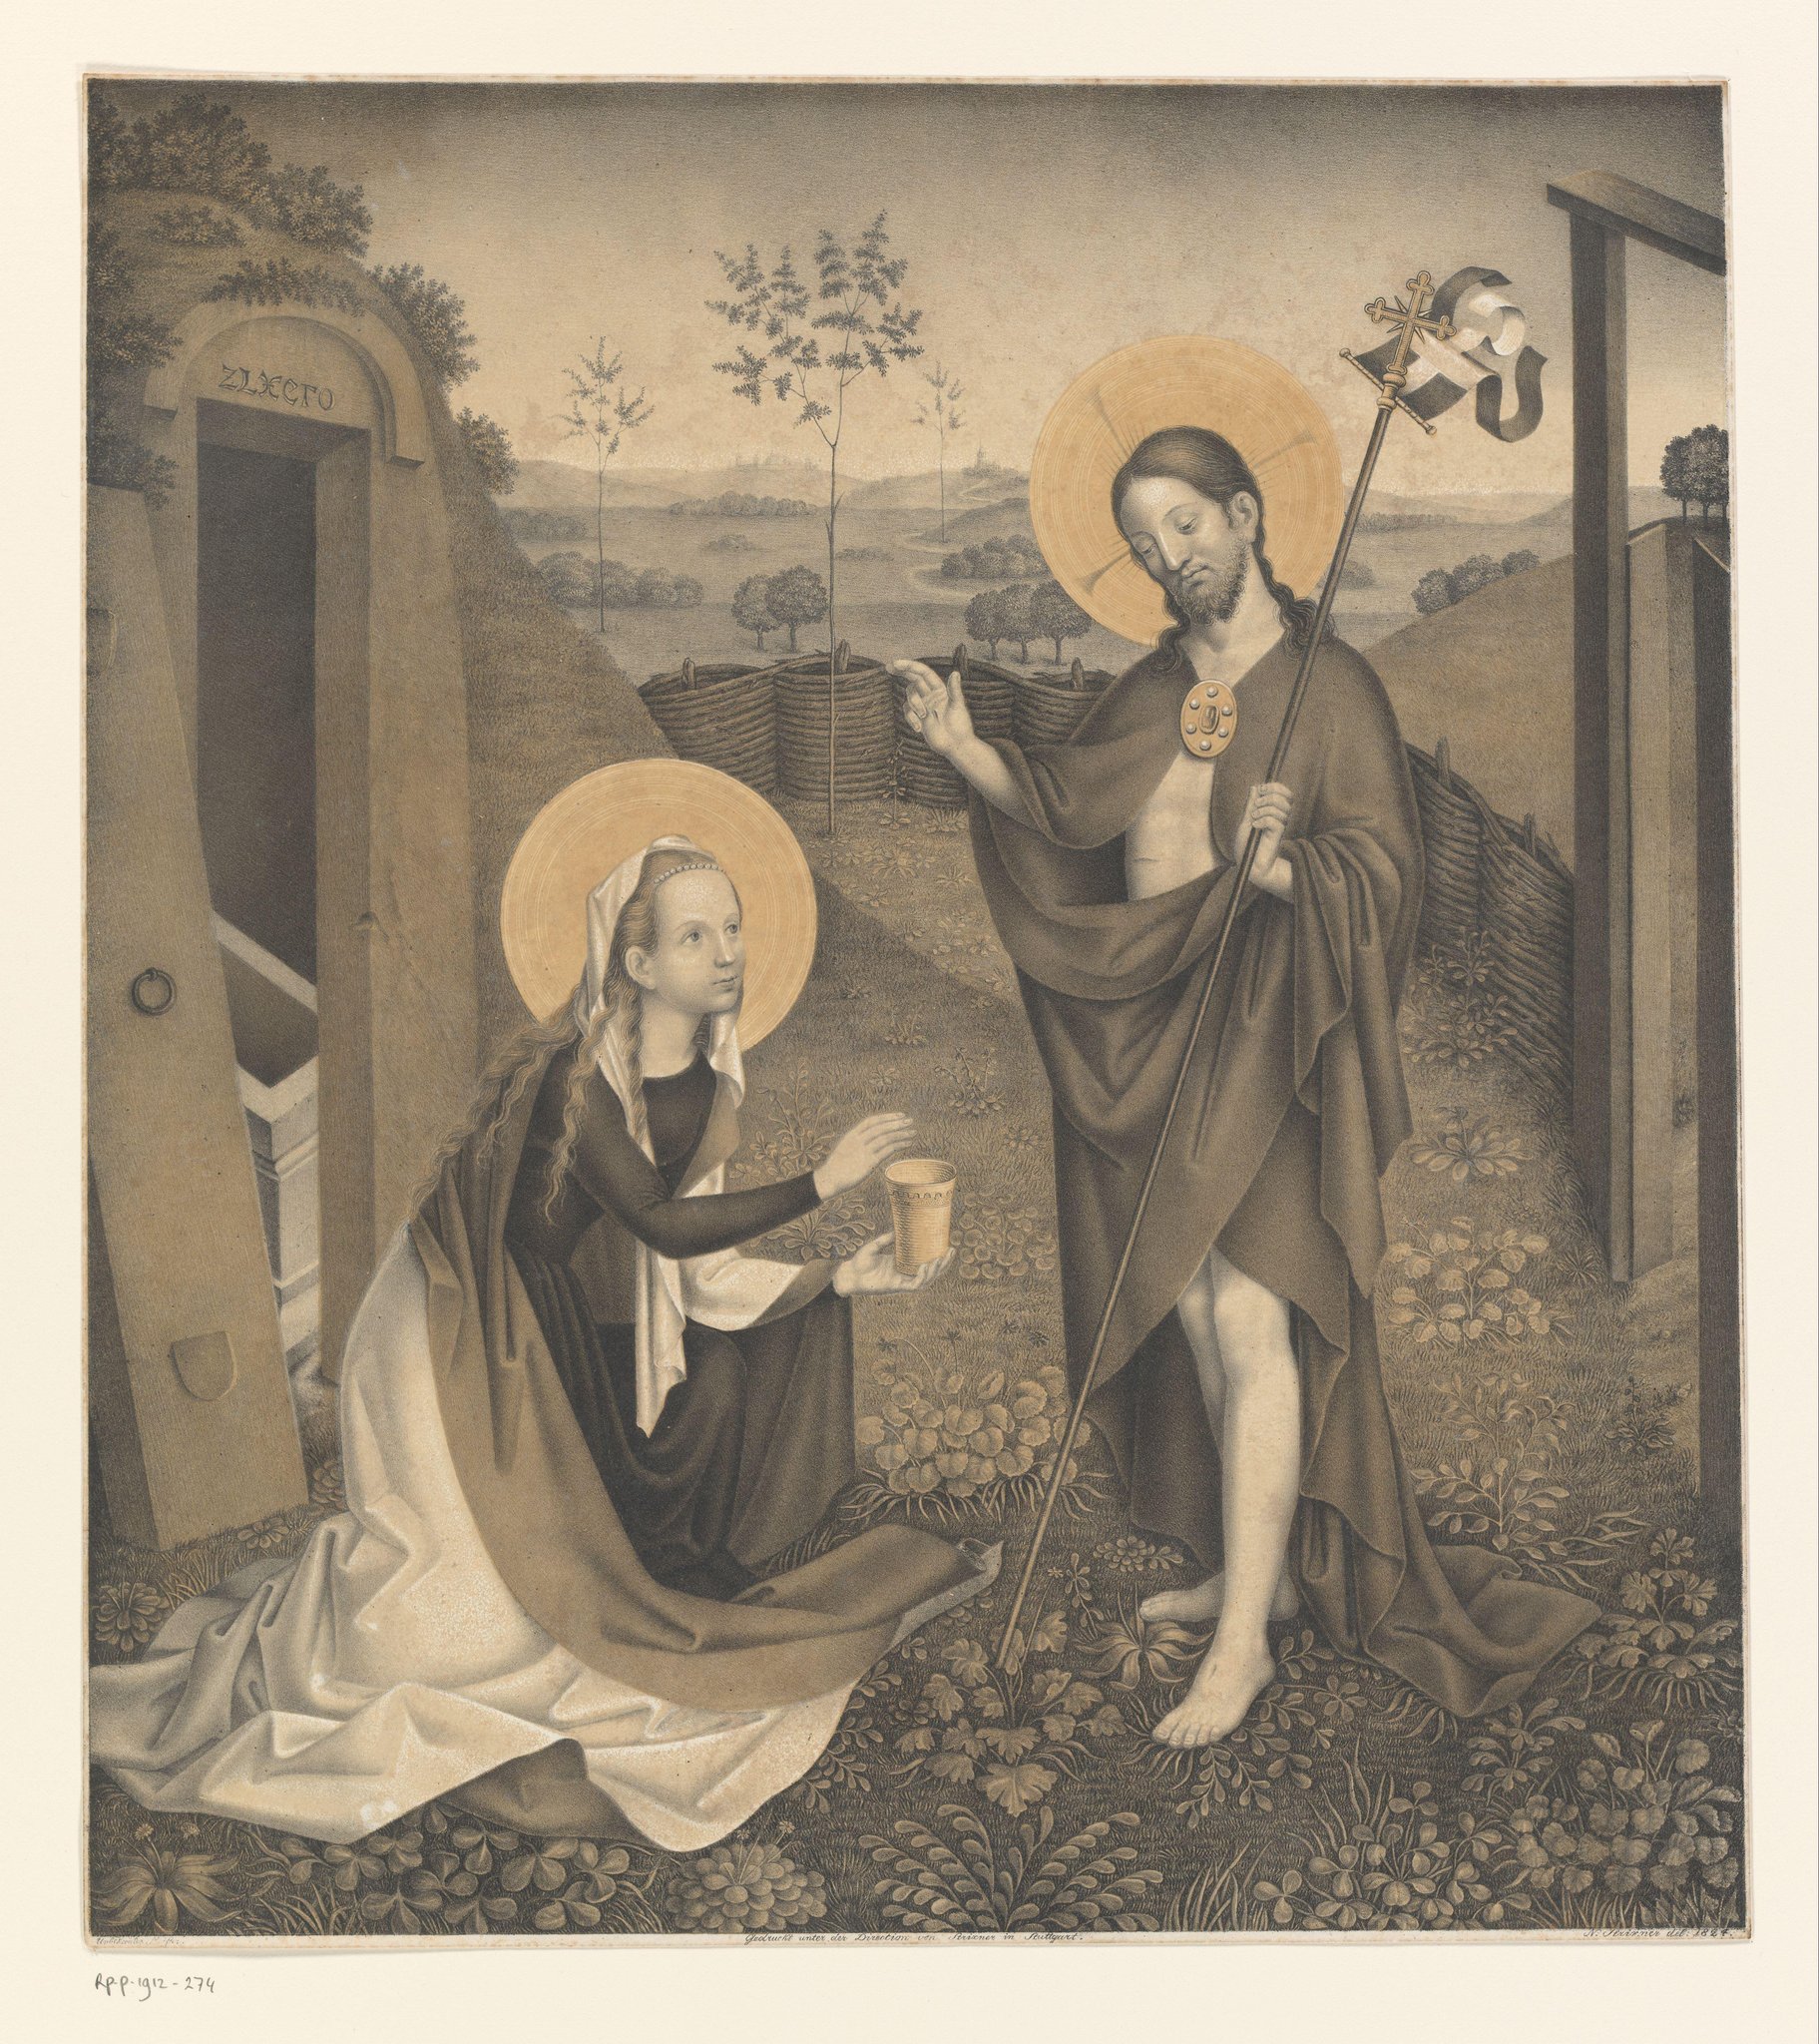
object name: print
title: Galerie des Frères Boisserée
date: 1824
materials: paper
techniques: tone lithography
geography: stuttgart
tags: mary magdalene kneeling before christ, who is usually represented as a gardener with a hoe and/or a spade; 'noli me tangere'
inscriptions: collector's mark: Lugt 2228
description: Deze prent behoort tot de serie 'Galerie des Frères Boisserée'. De serie is in 38 delen uitgegeven met drie prenten per deel en nog drie extra inleidende prenten. Deze prent verscheen in het zeventiende deel.